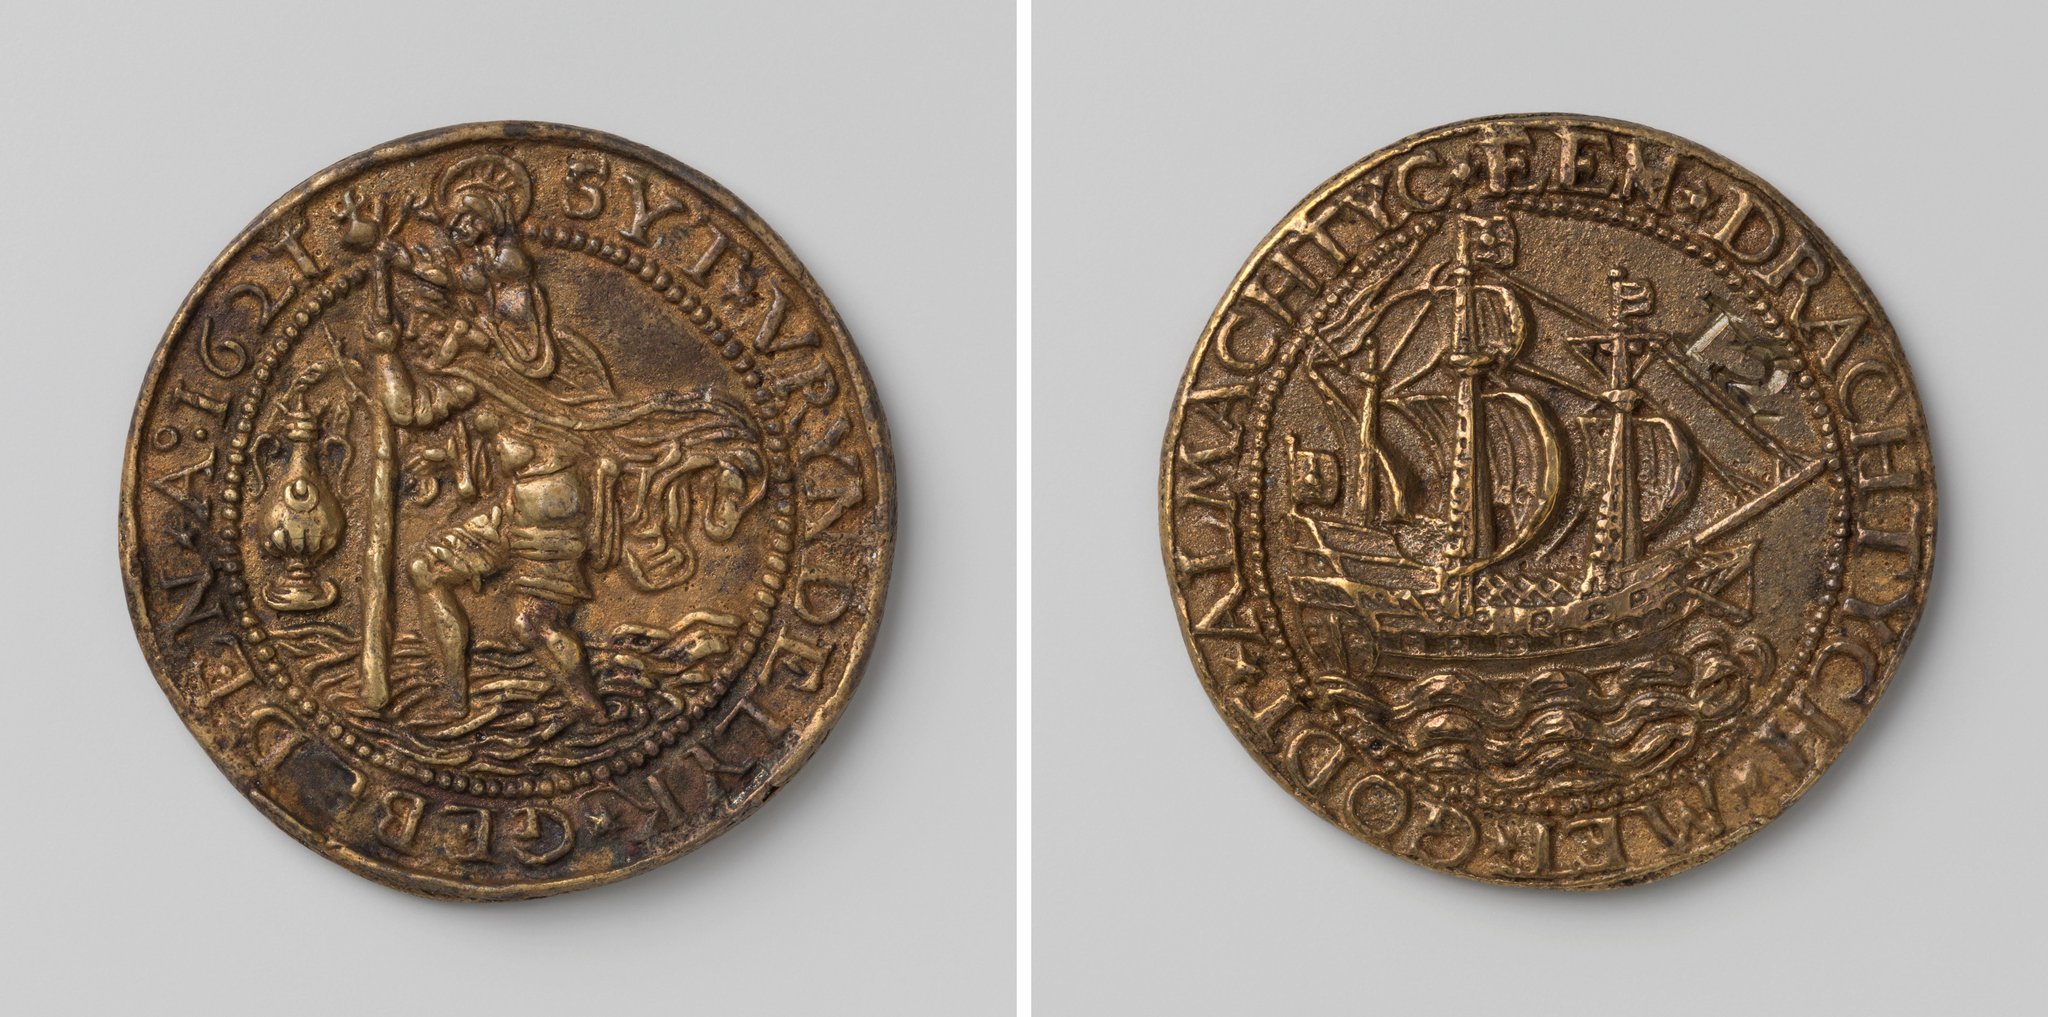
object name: medal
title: Schuitmansgilde van Vlissingen, gildepenning met no. 12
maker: Anonymous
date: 1621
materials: brass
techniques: casting, engraving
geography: flushing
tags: flushing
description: Guilds were urban organisations of people in specific occupations. The guild represented the interests of the profession. Each member had a token as proof of membership. The person’s name was engraved on one side of the token, often together with the arms of the guild or of the city in which it was based. The other side carried a motif signifying the occupation represented by the guild.